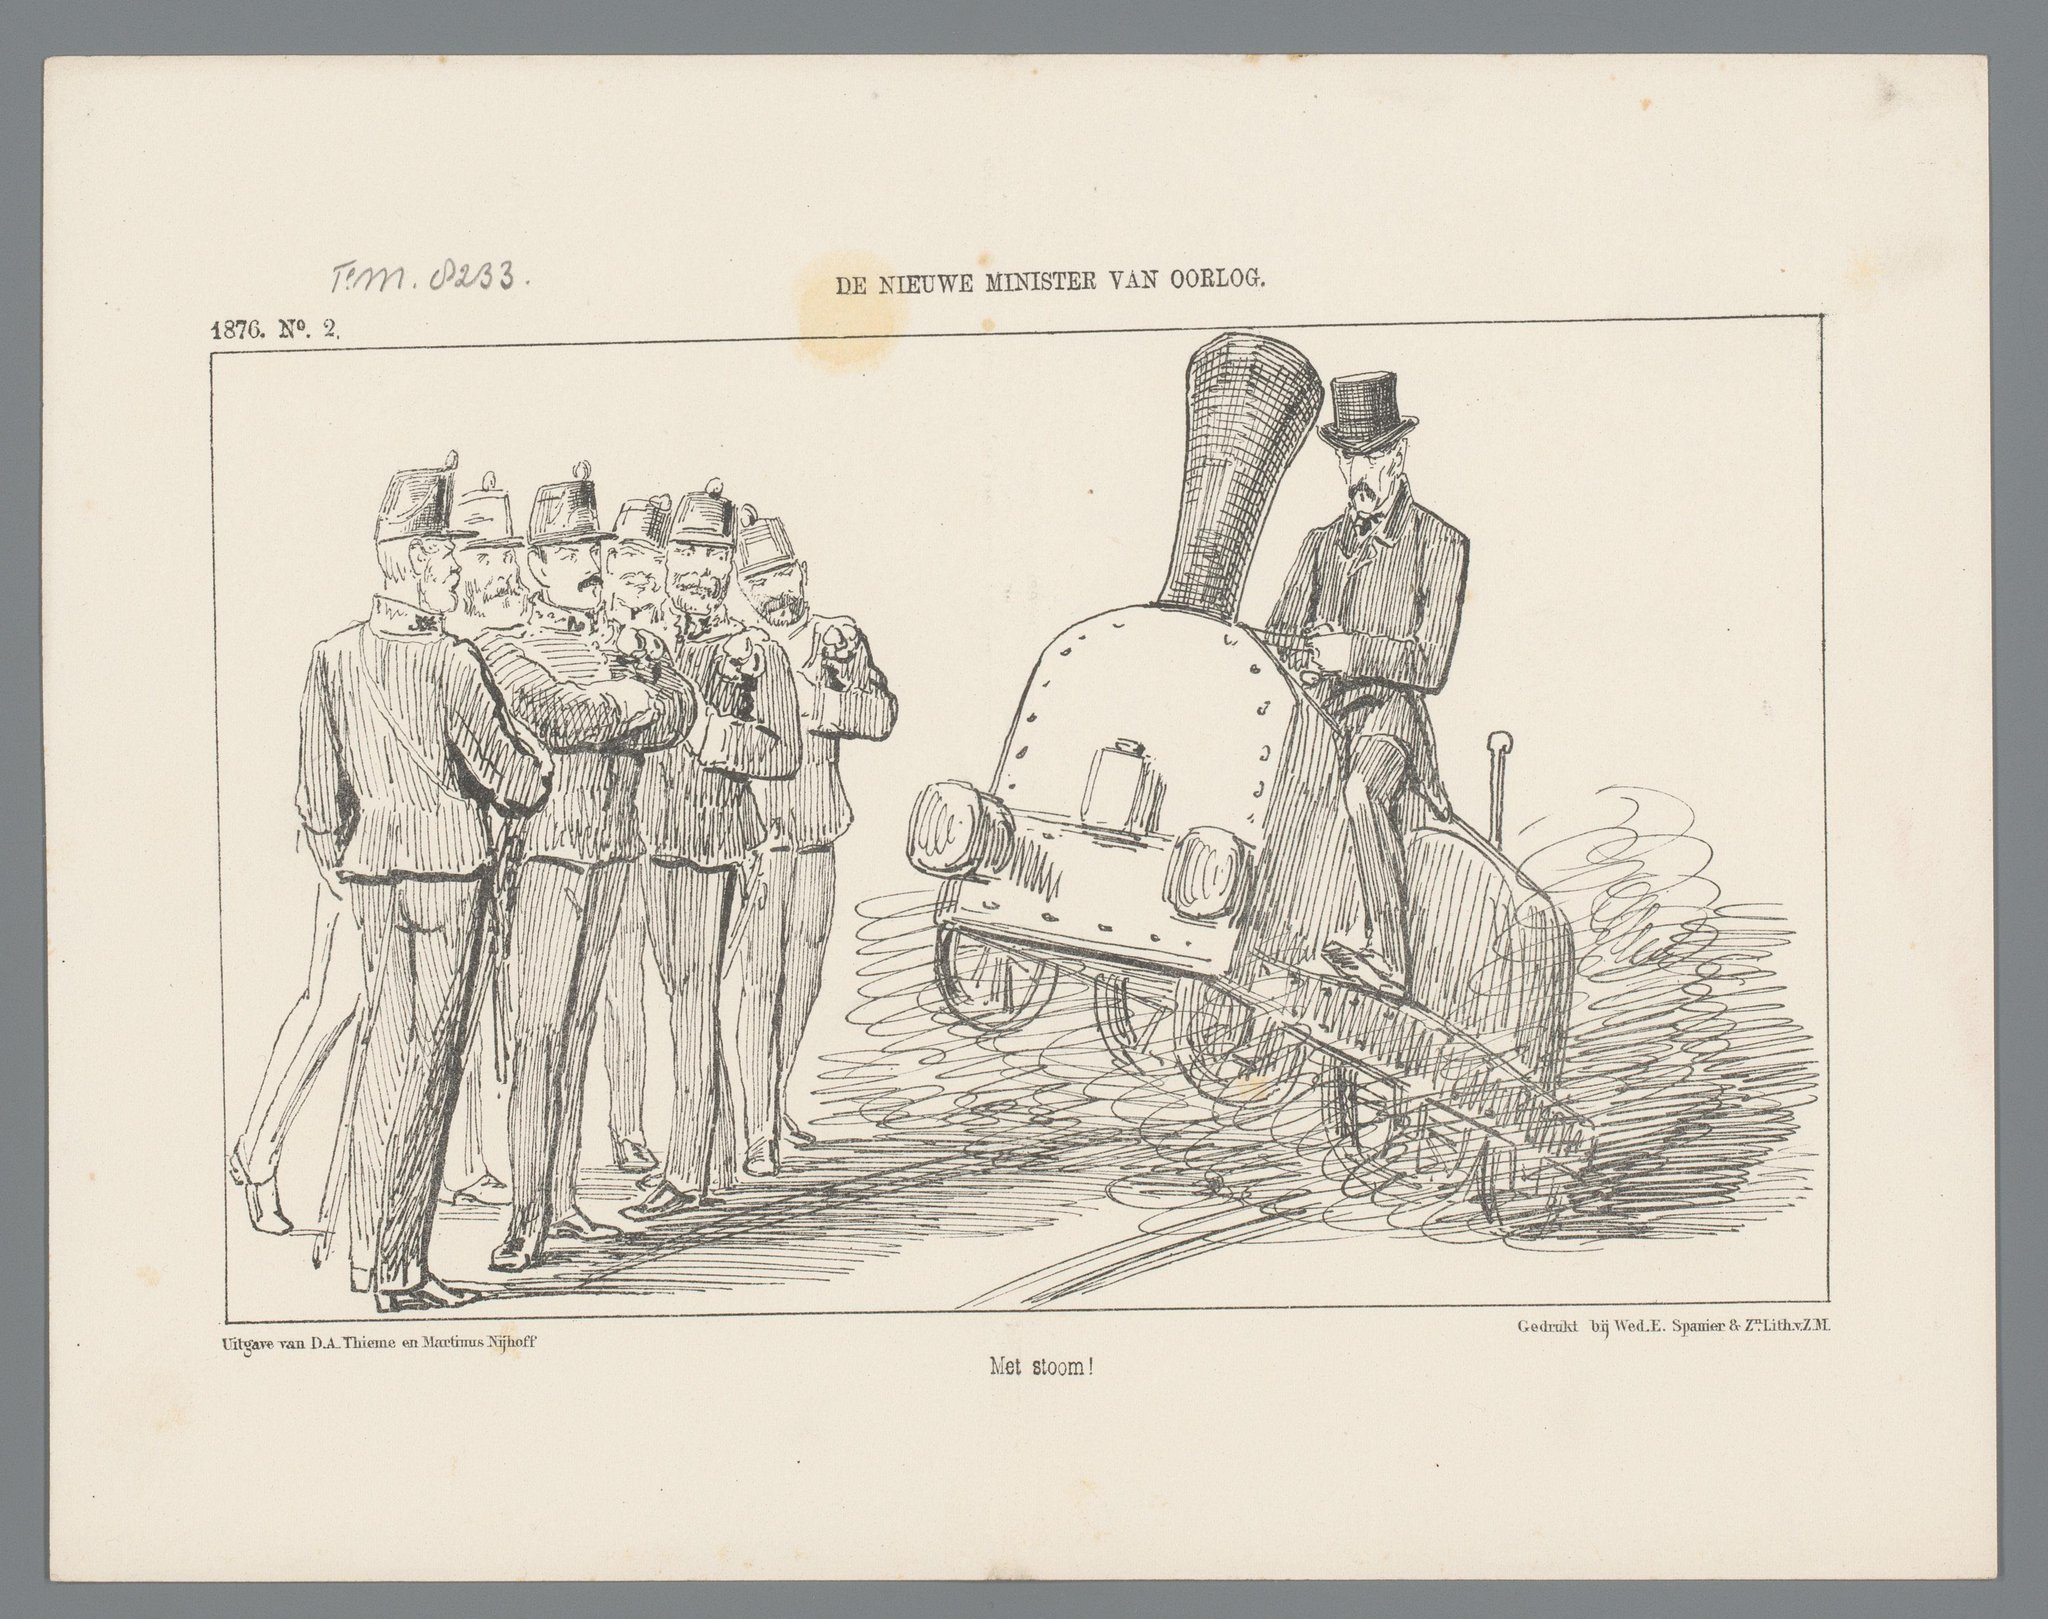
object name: cartoon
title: De nieuwe Minister van Oorlog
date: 1876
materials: paper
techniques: lithograph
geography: netherlands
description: Spotprent . Plaat verschenen bij het weekblad De Nederlandsche Spectator, nr. 2, 1876.